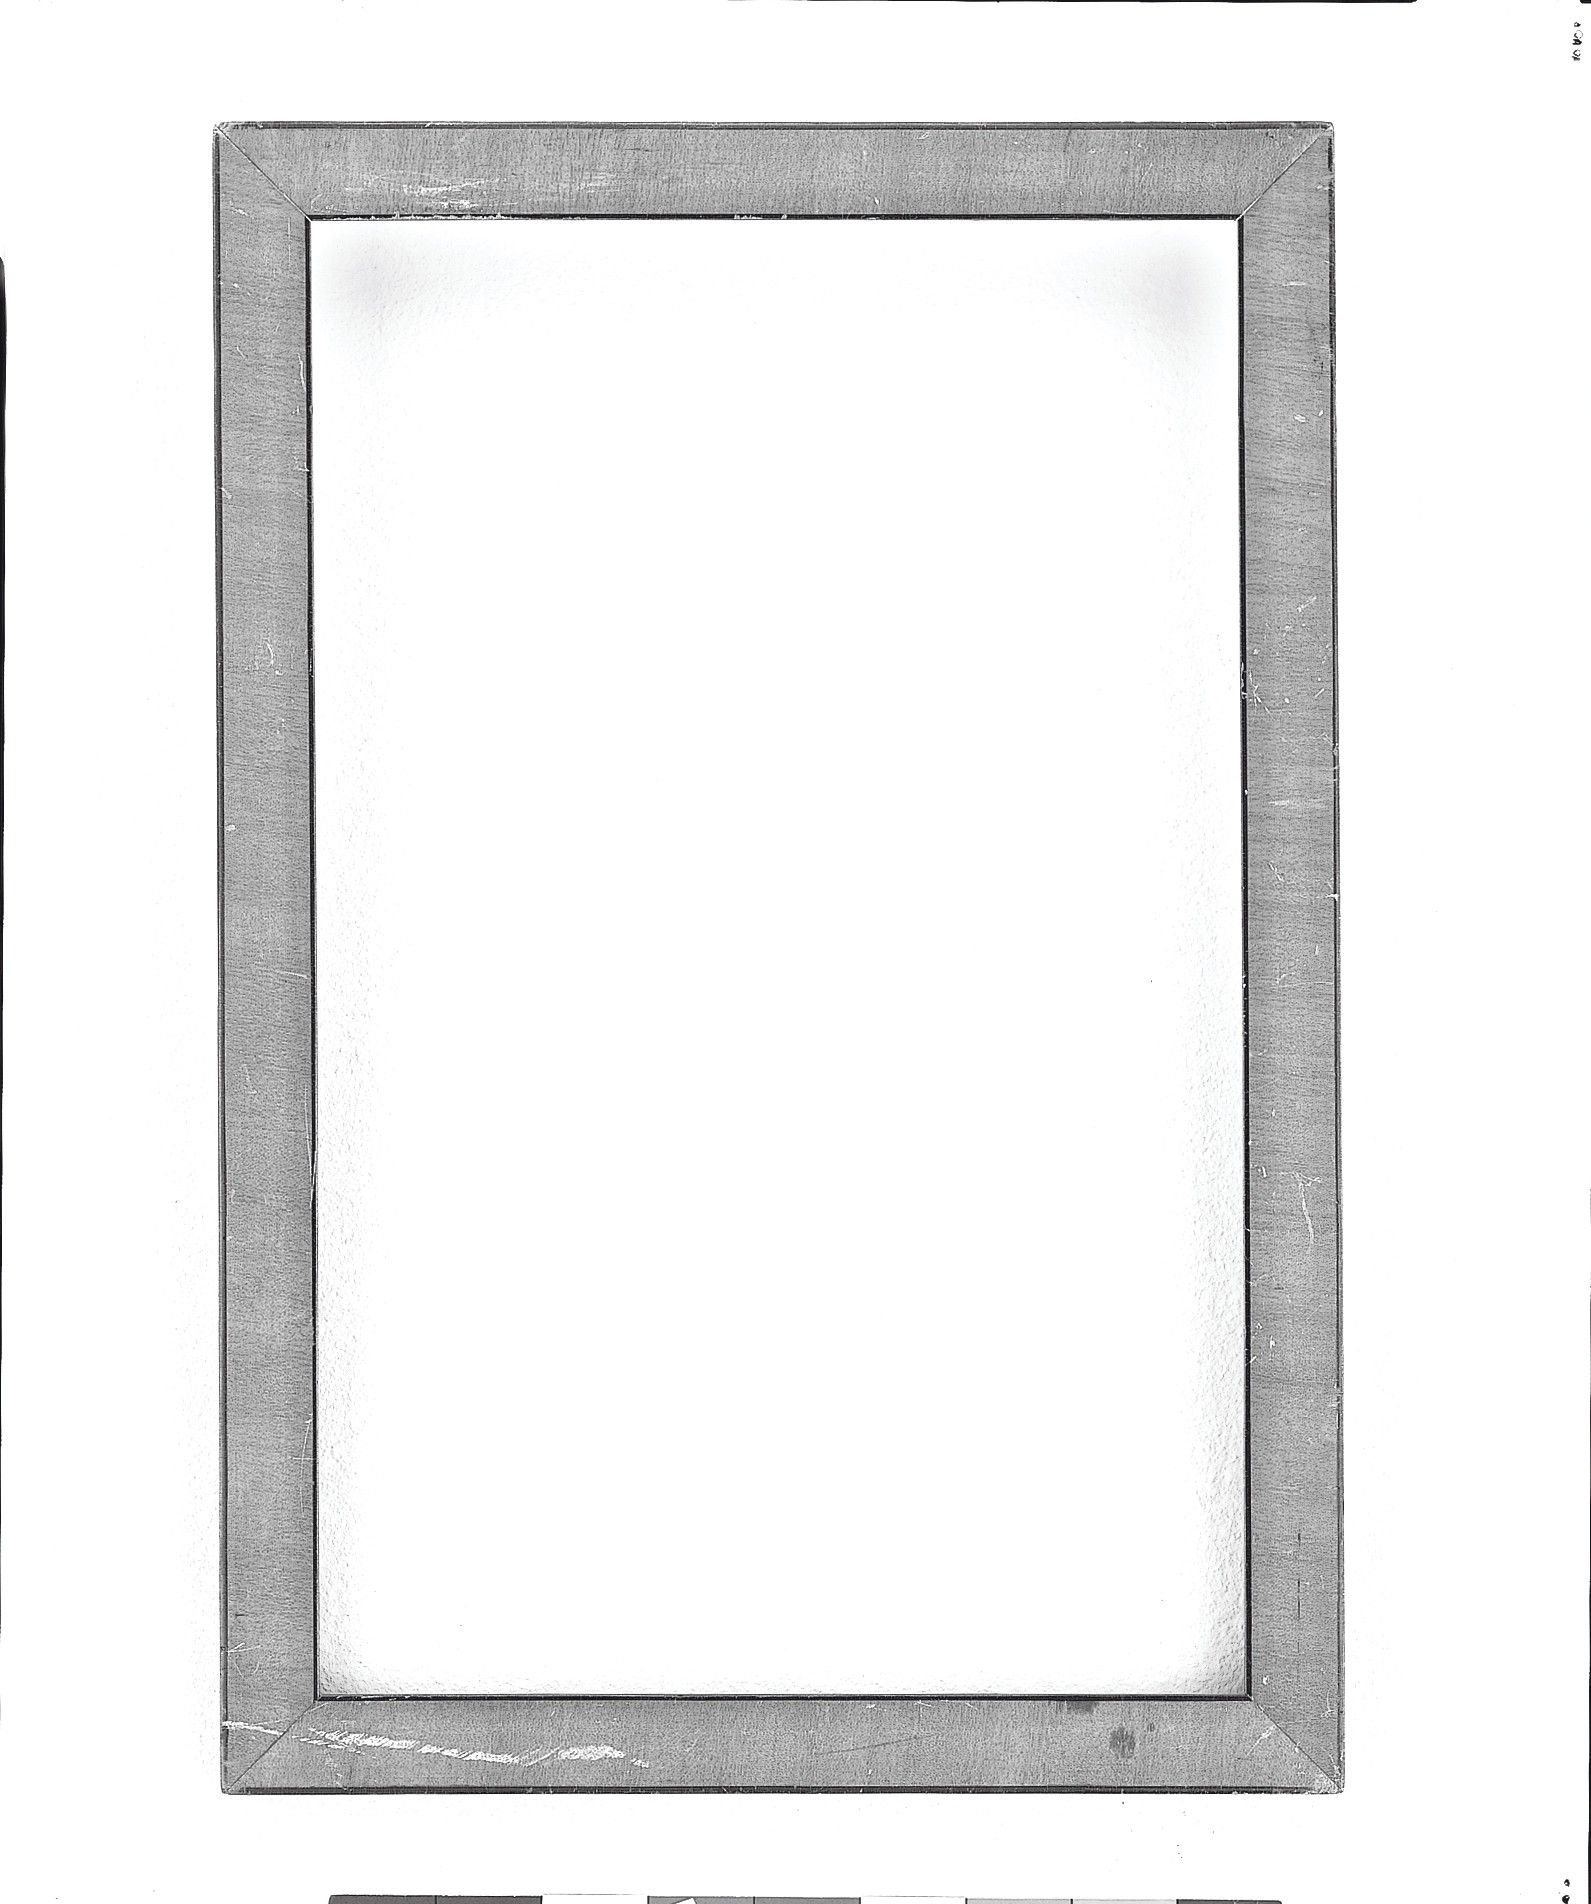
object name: frame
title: Biedermeier frame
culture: german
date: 1830-1840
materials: wood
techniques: veneering